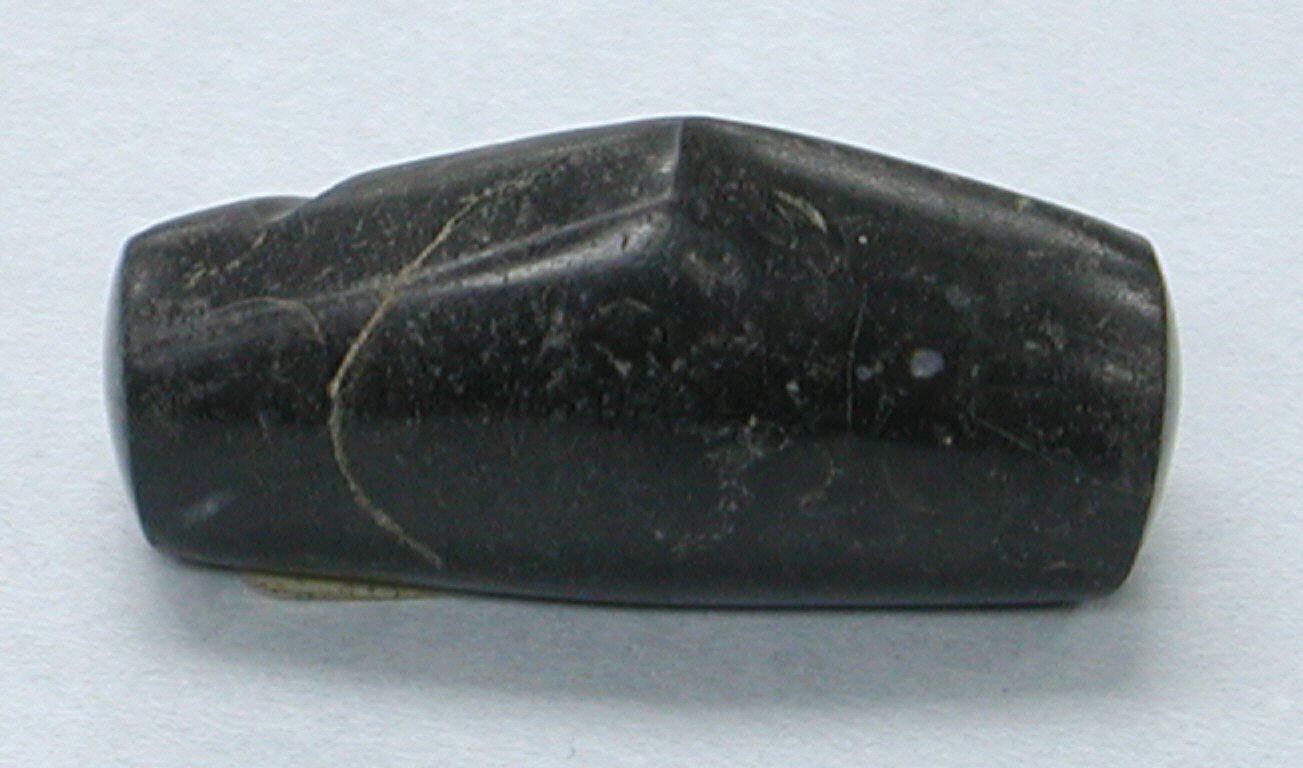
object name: ritual stone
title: Stone Pulidor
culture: mexican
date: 1501-1600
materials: stone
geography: mexico